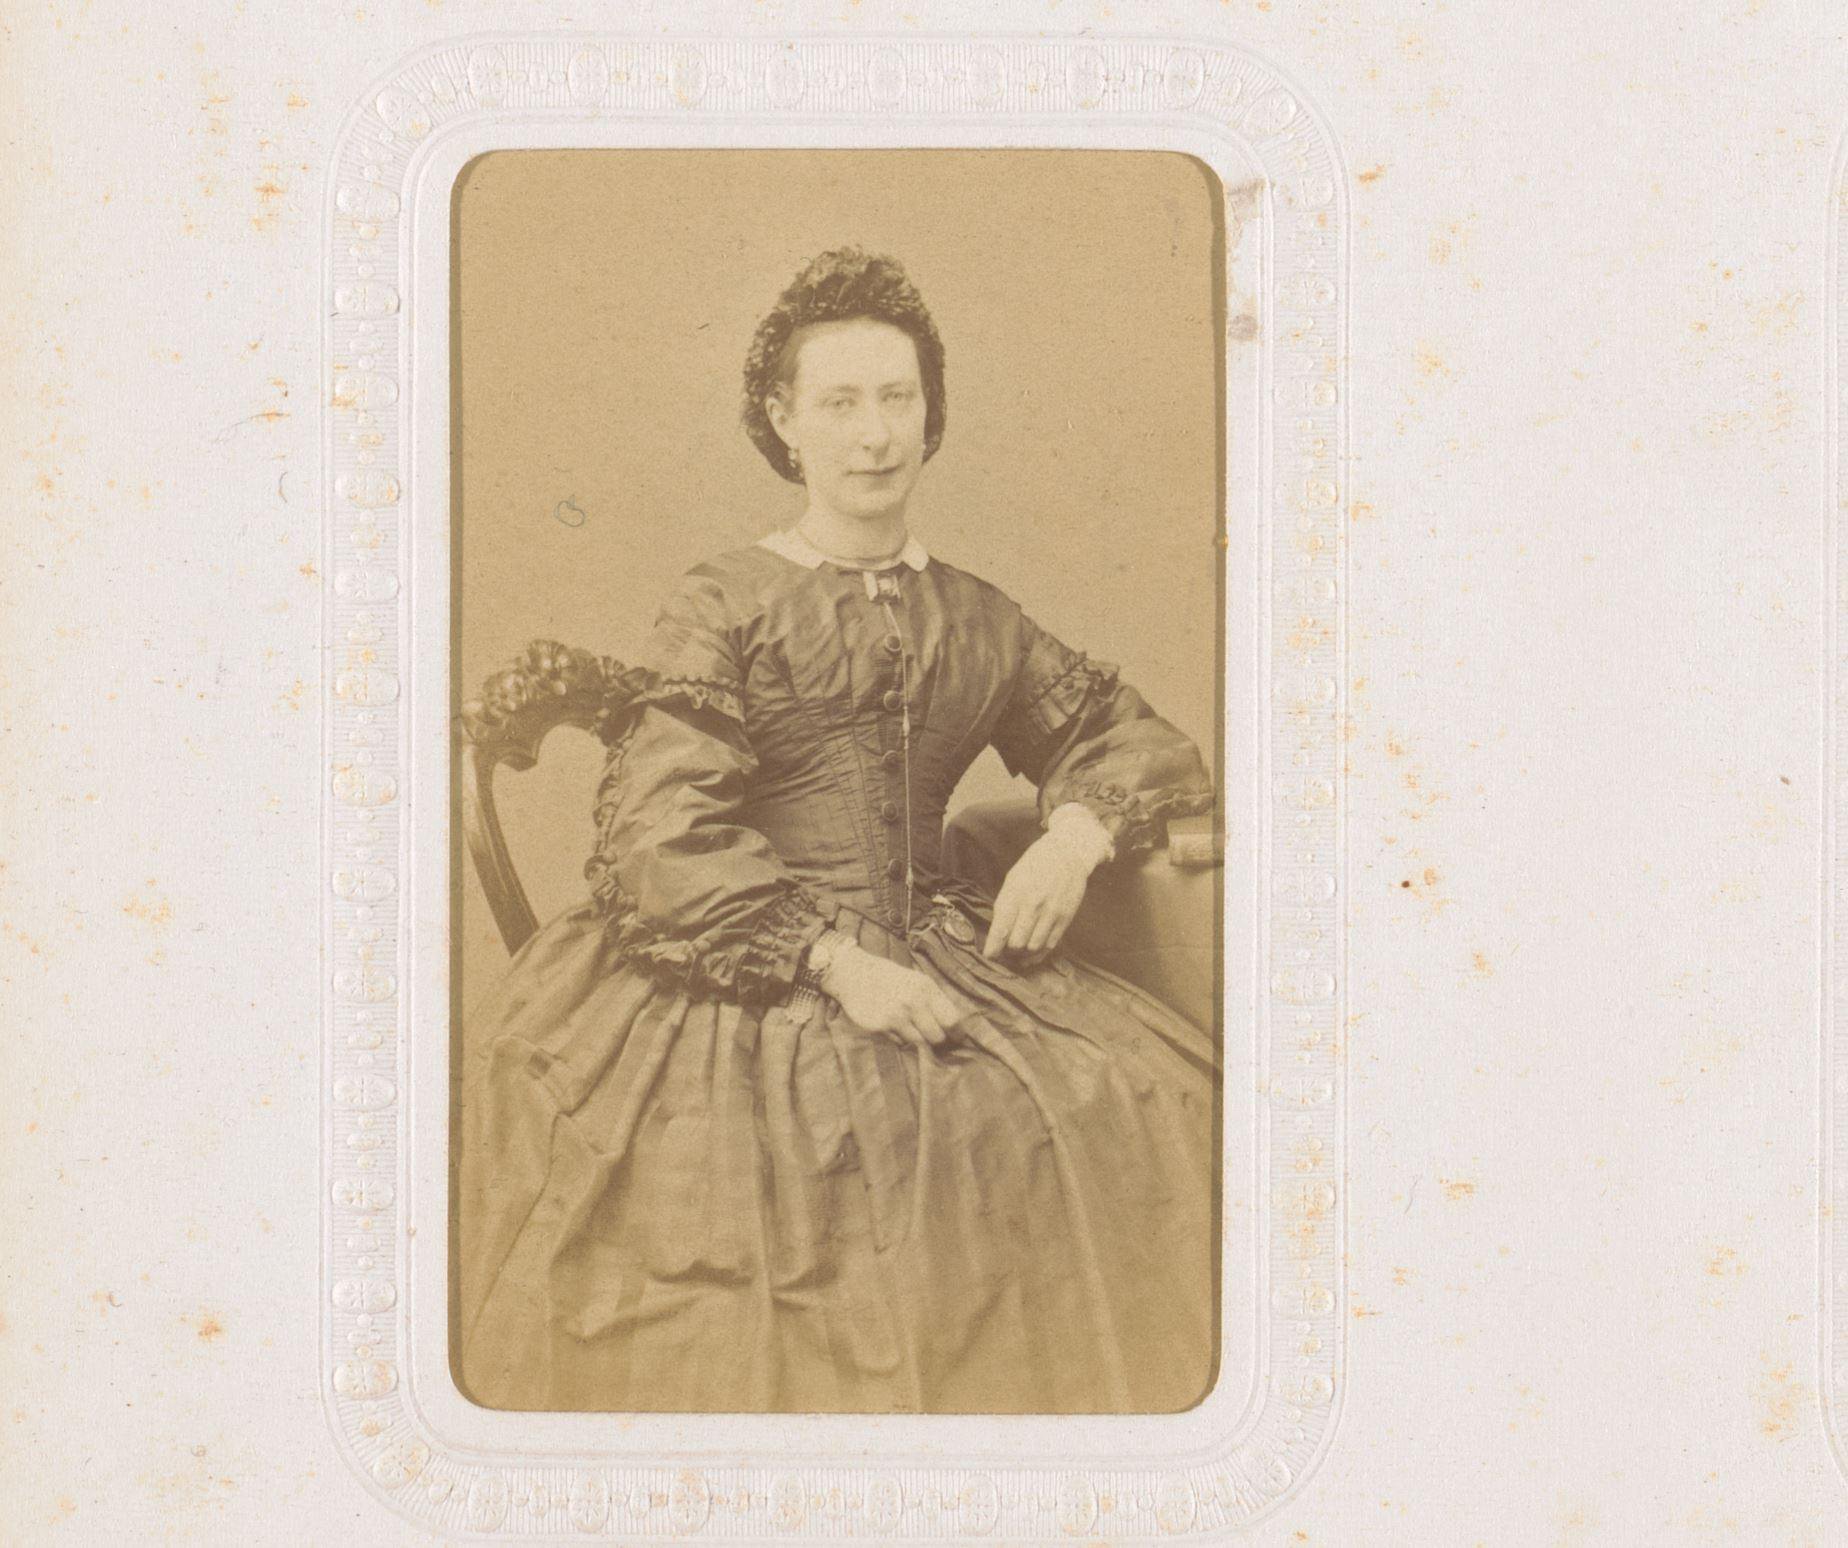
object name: carte de visite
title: Portret van een zittende vrouw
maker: Anonymous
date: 1850-1880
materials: cardboard, photographic support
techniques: albumen print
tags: adult woman, historical persons - bb - woman